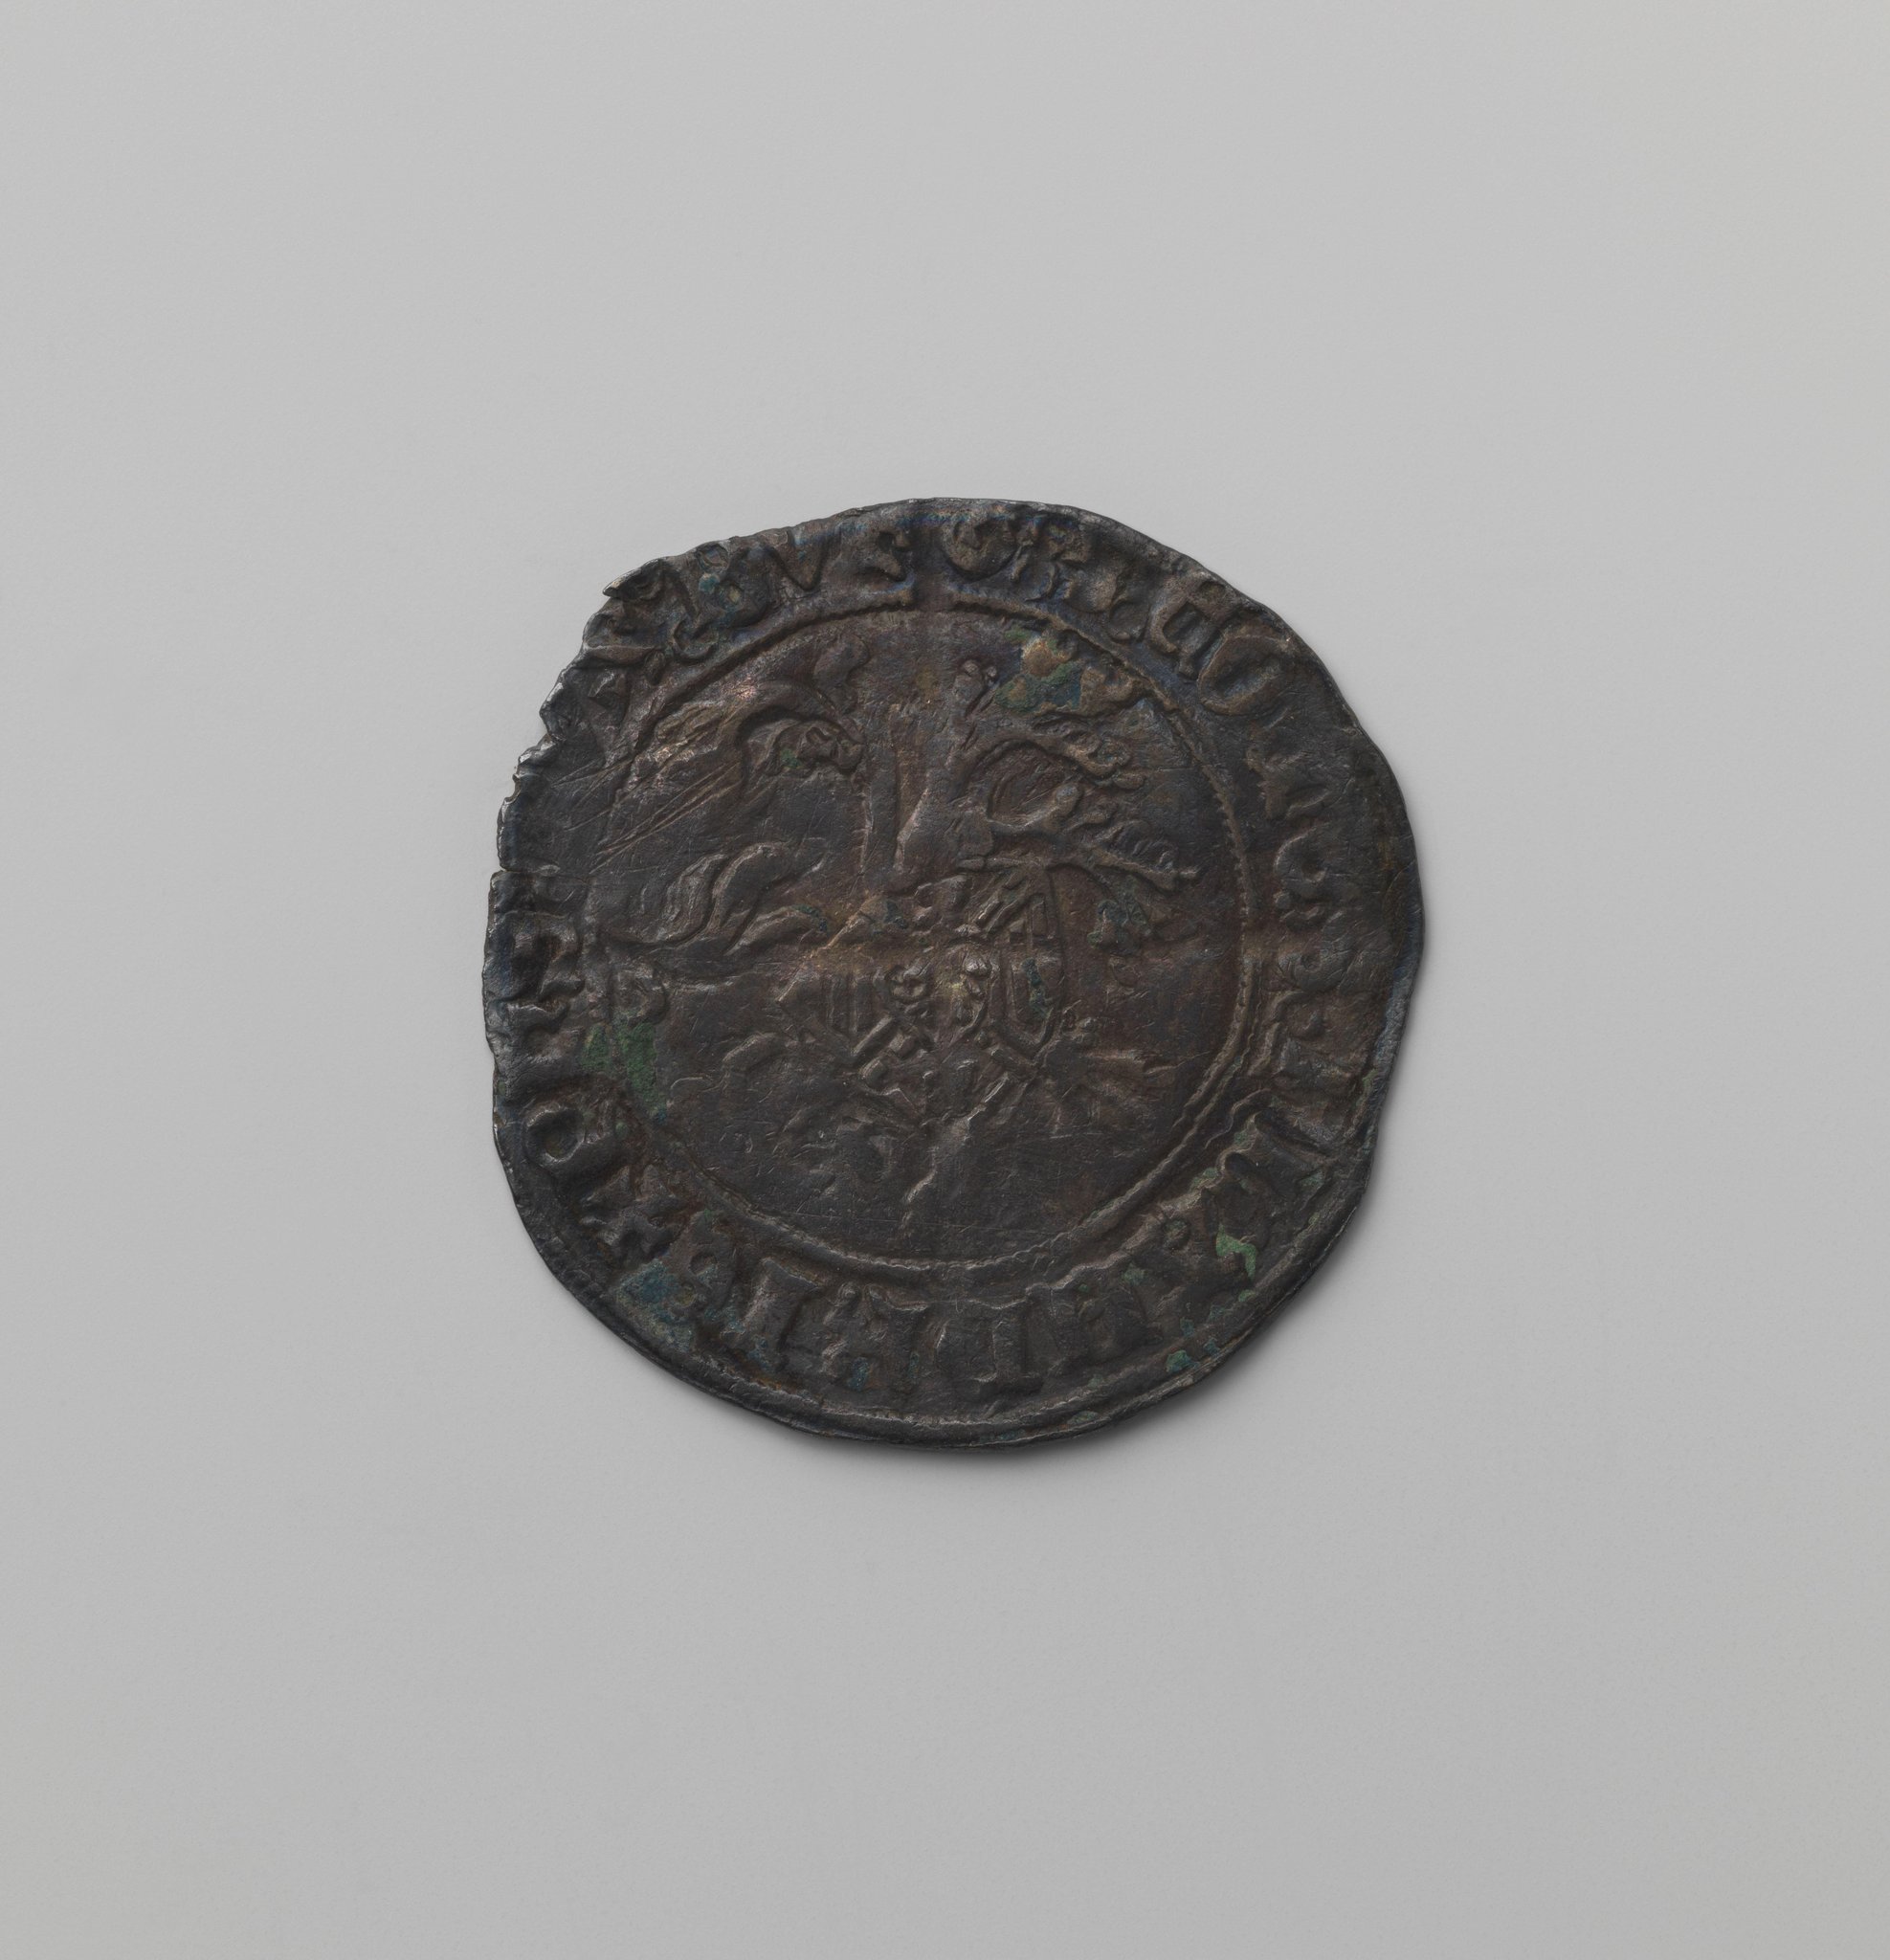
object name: coin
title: Kromstaart uit Vlaanderen van Philips de Goede, 1419-1467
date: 1419-1467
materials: silver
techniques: striking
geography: ghent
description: Voorzijde: klimmende leeuw naar links, op de borst wapenschild. Keerzijde: lang gevoet kruis, in de hoeken letters F,L,A en D'.